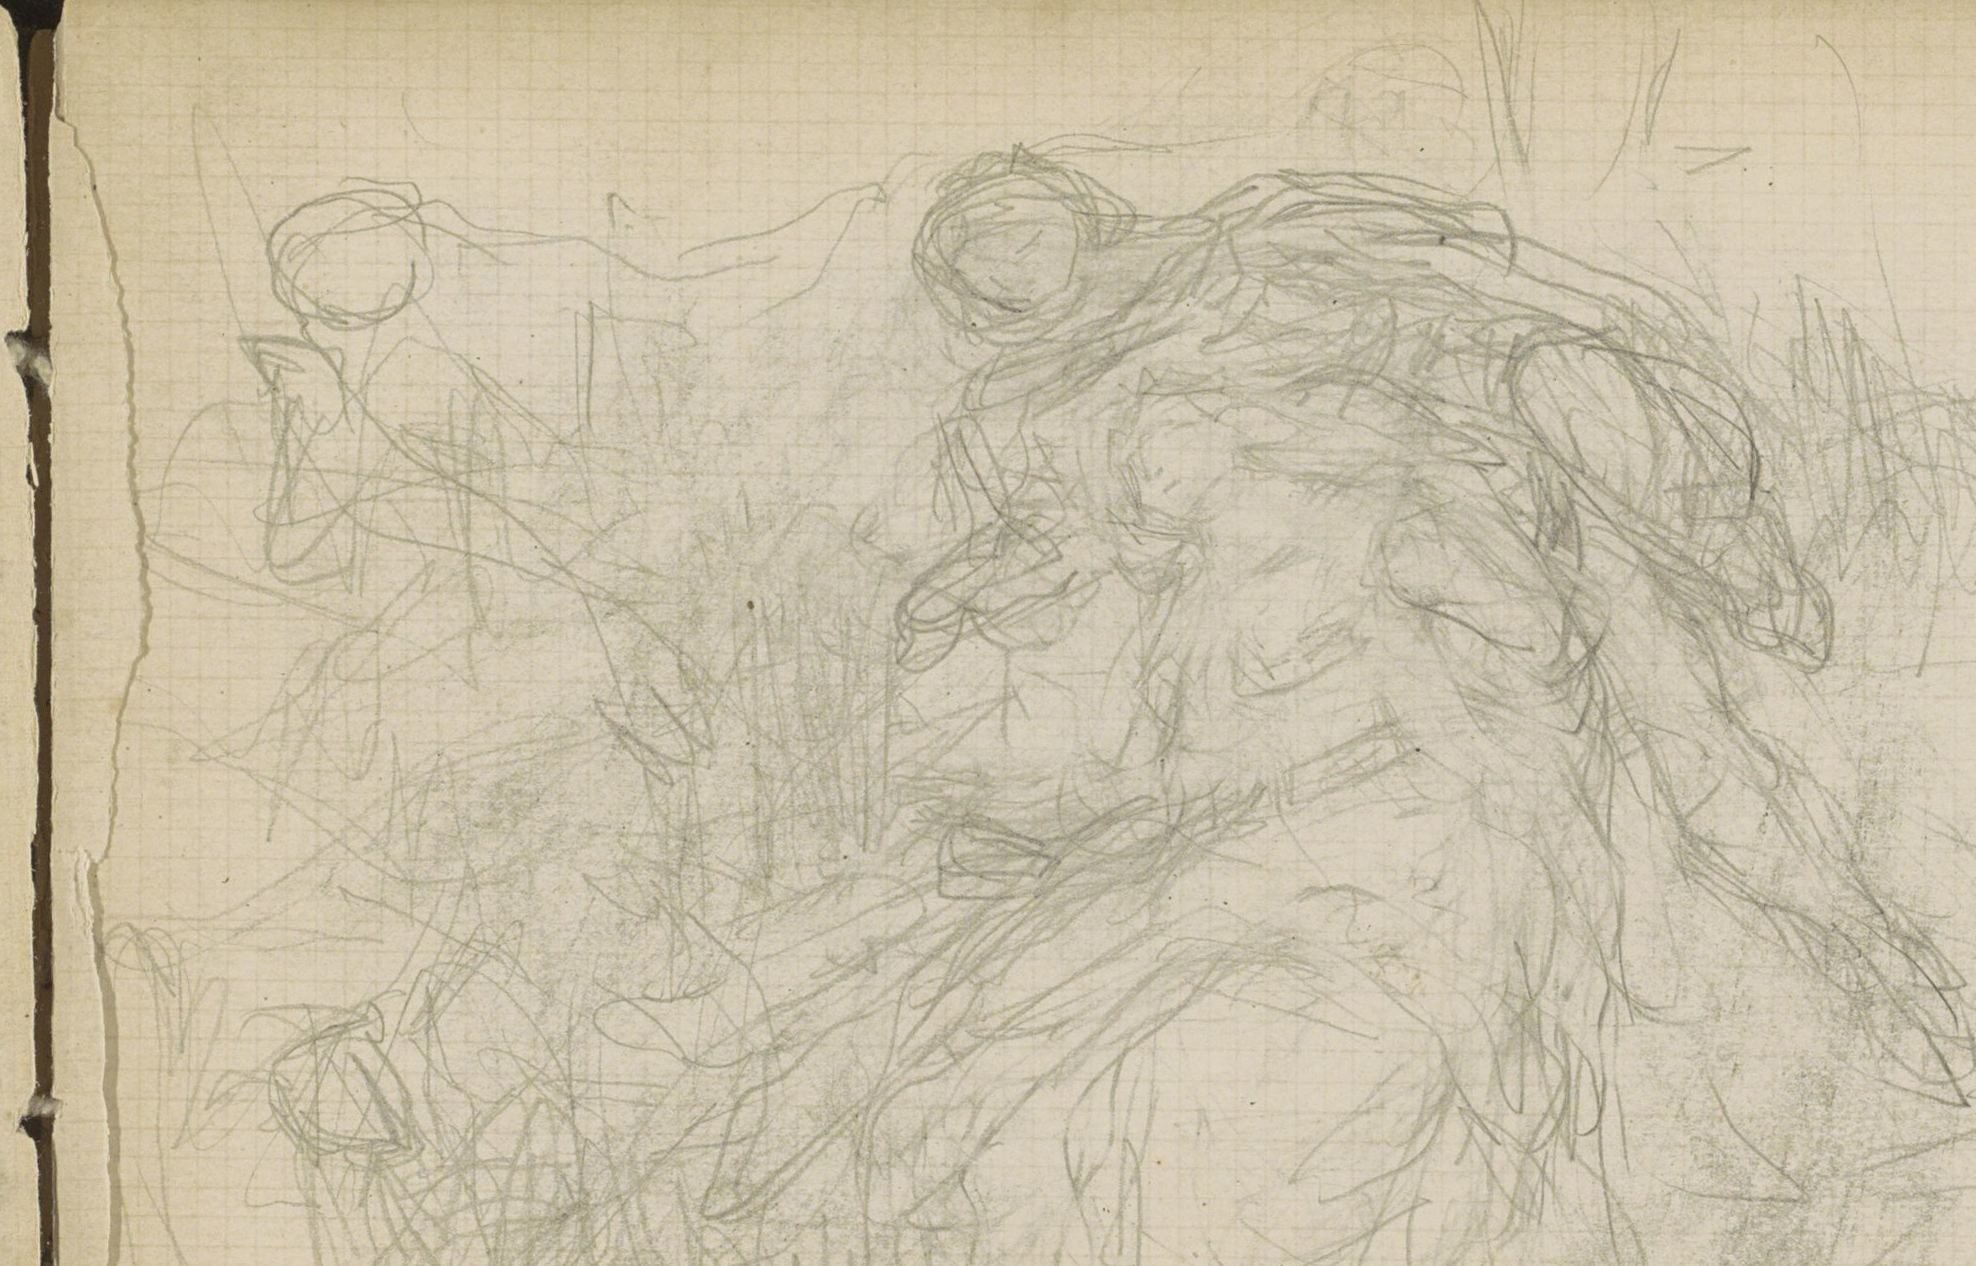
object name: sketchbook leaf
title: Zittende vrouw met het hoofd tegen de borst van een man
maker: matthijs maris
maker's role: draughtsman, painter, print maker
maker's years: 1839-1917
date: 1849-1917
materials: pencil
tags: sitting figure (+ female (human being) (not to be used where -aa- is prescribed)), adult man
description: Blad 35 recto uit een schetsboek met 35 bladen.